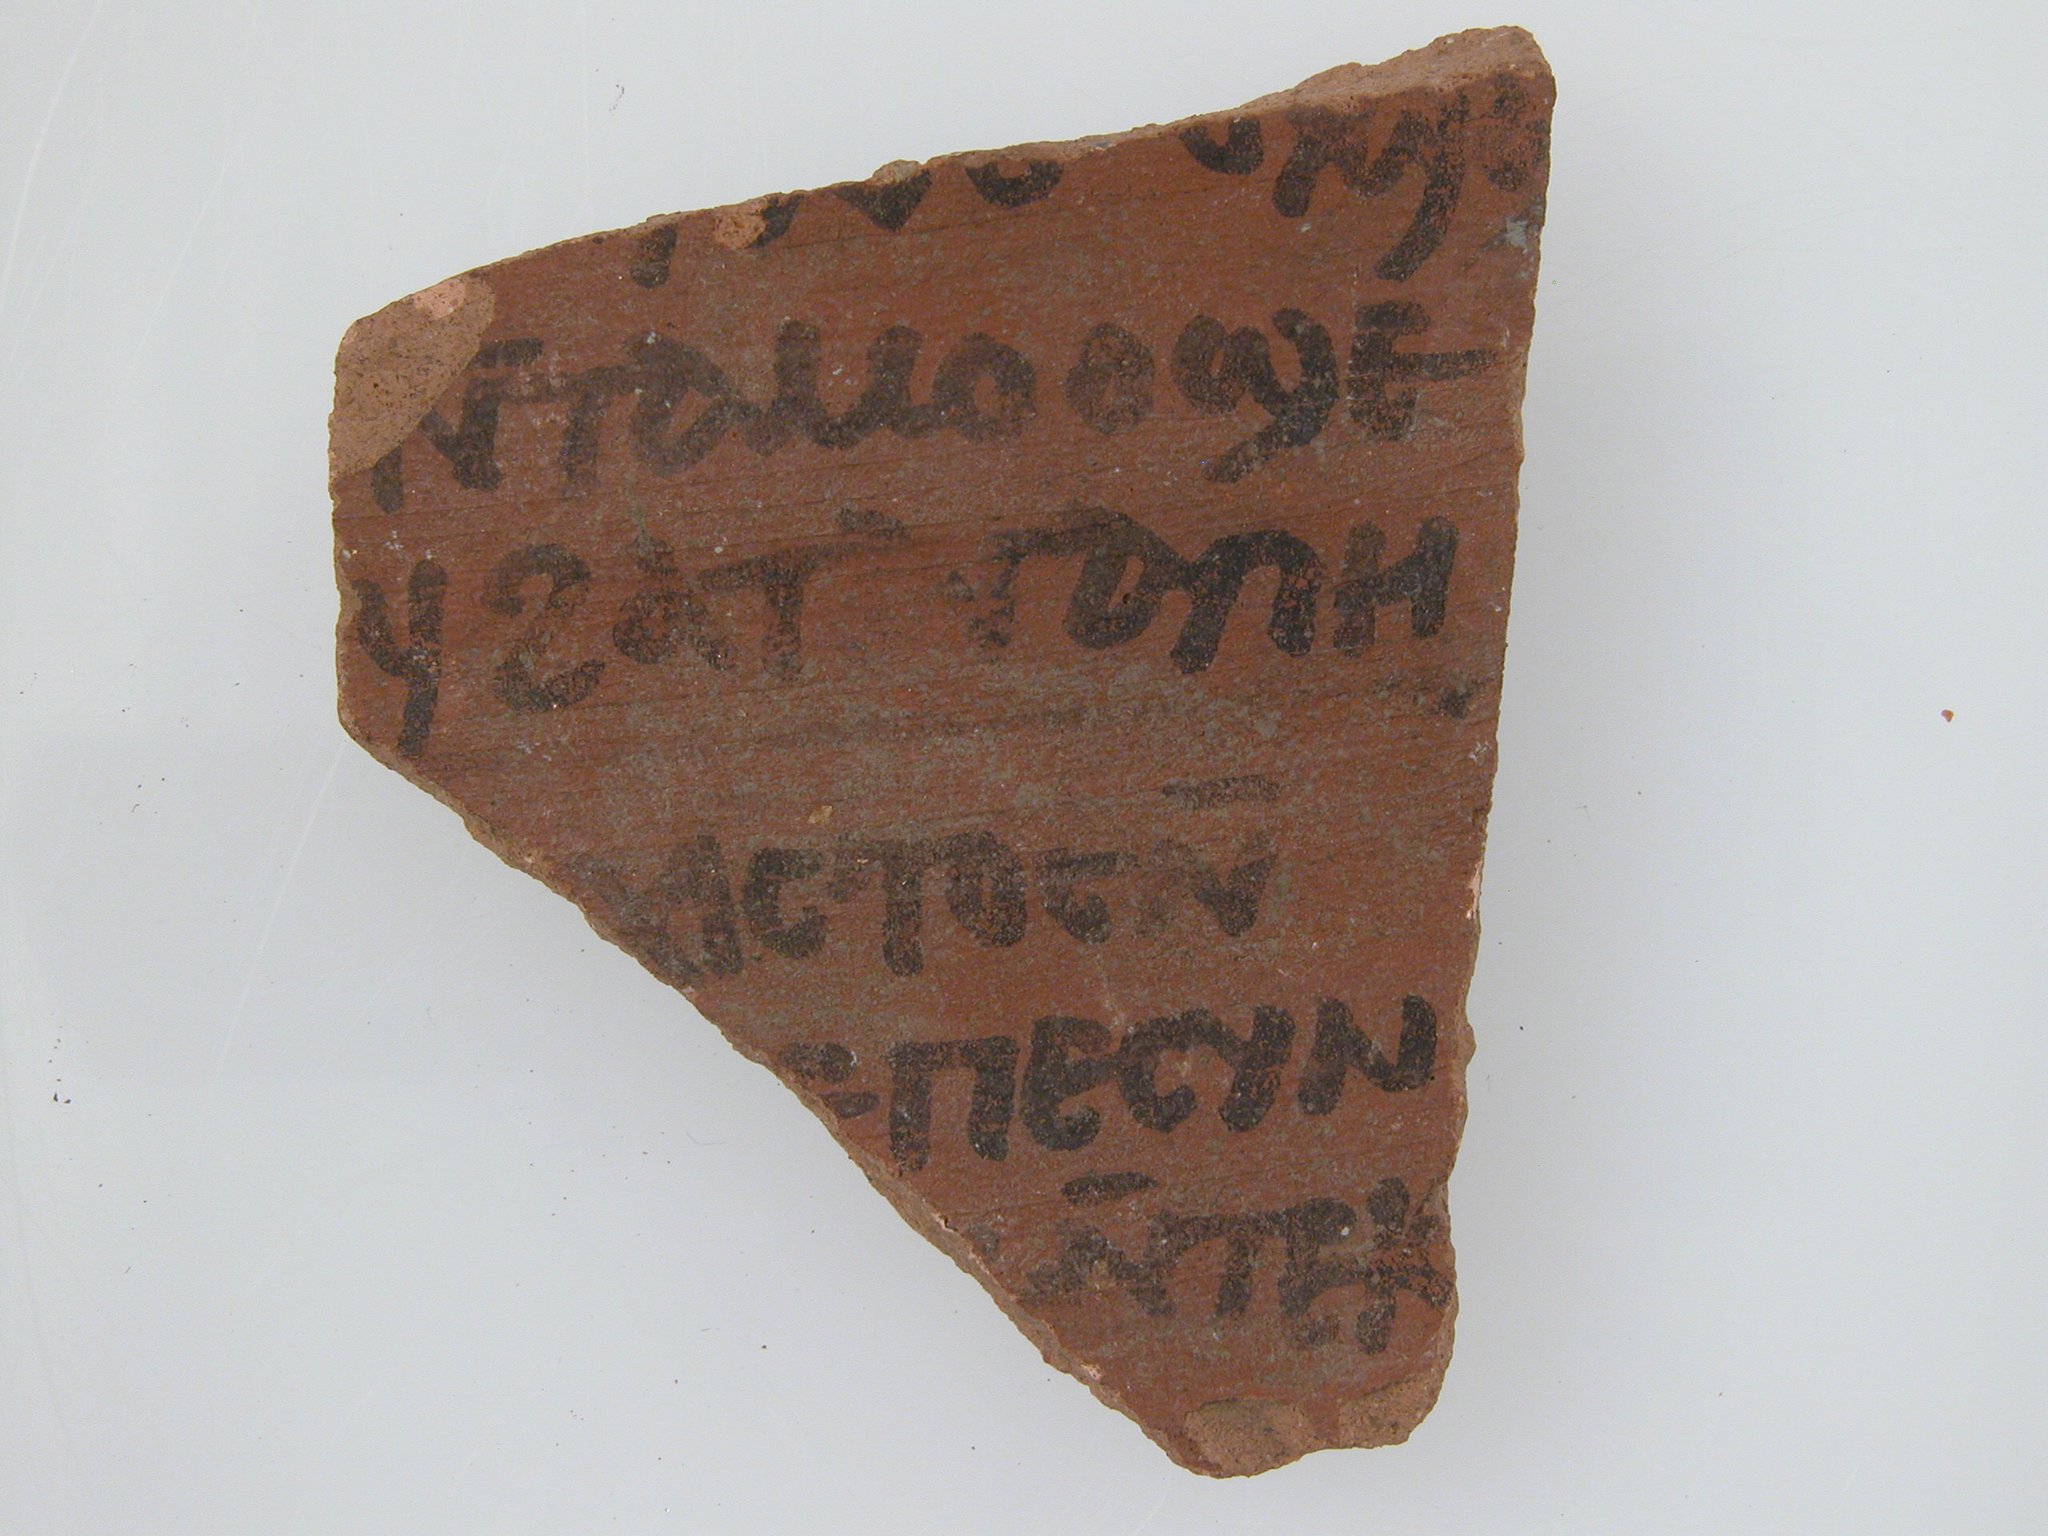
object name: ostrakon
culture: coptic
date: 600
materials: ink, pottery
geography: egypt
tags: coptic,documents